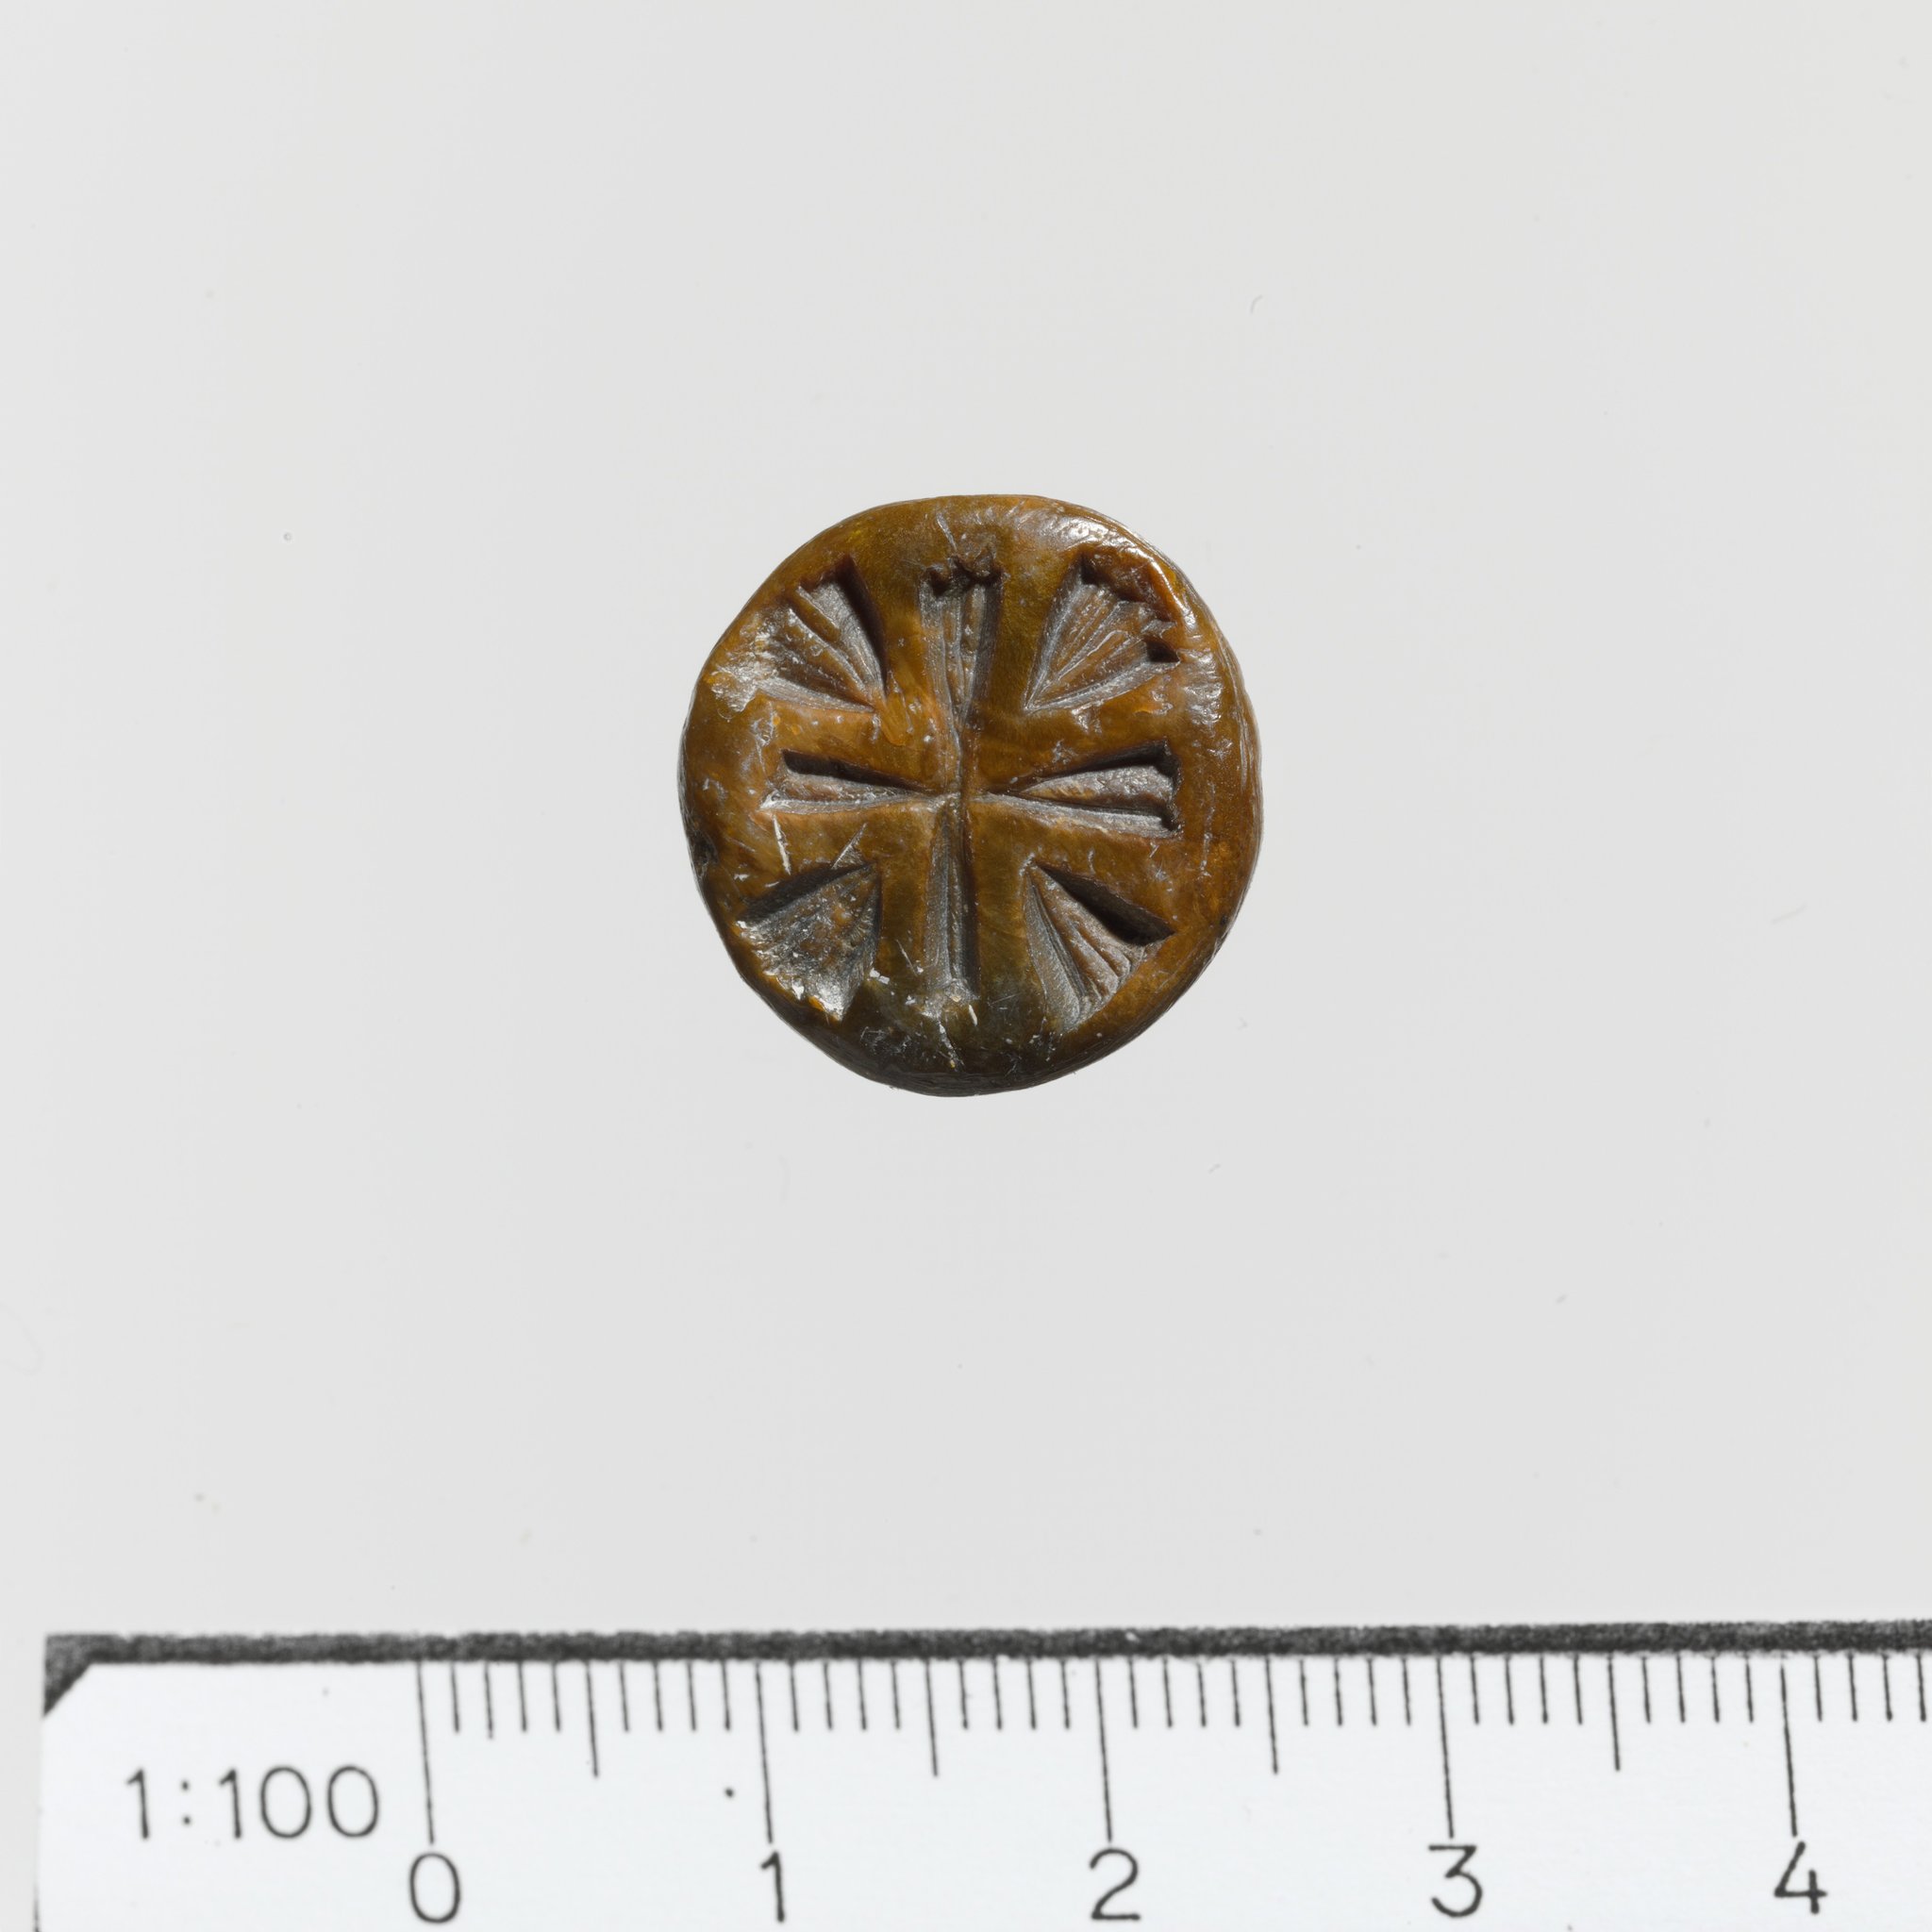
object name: hemispheroid seal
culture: minoan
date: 2100-1900 BCE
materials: stone